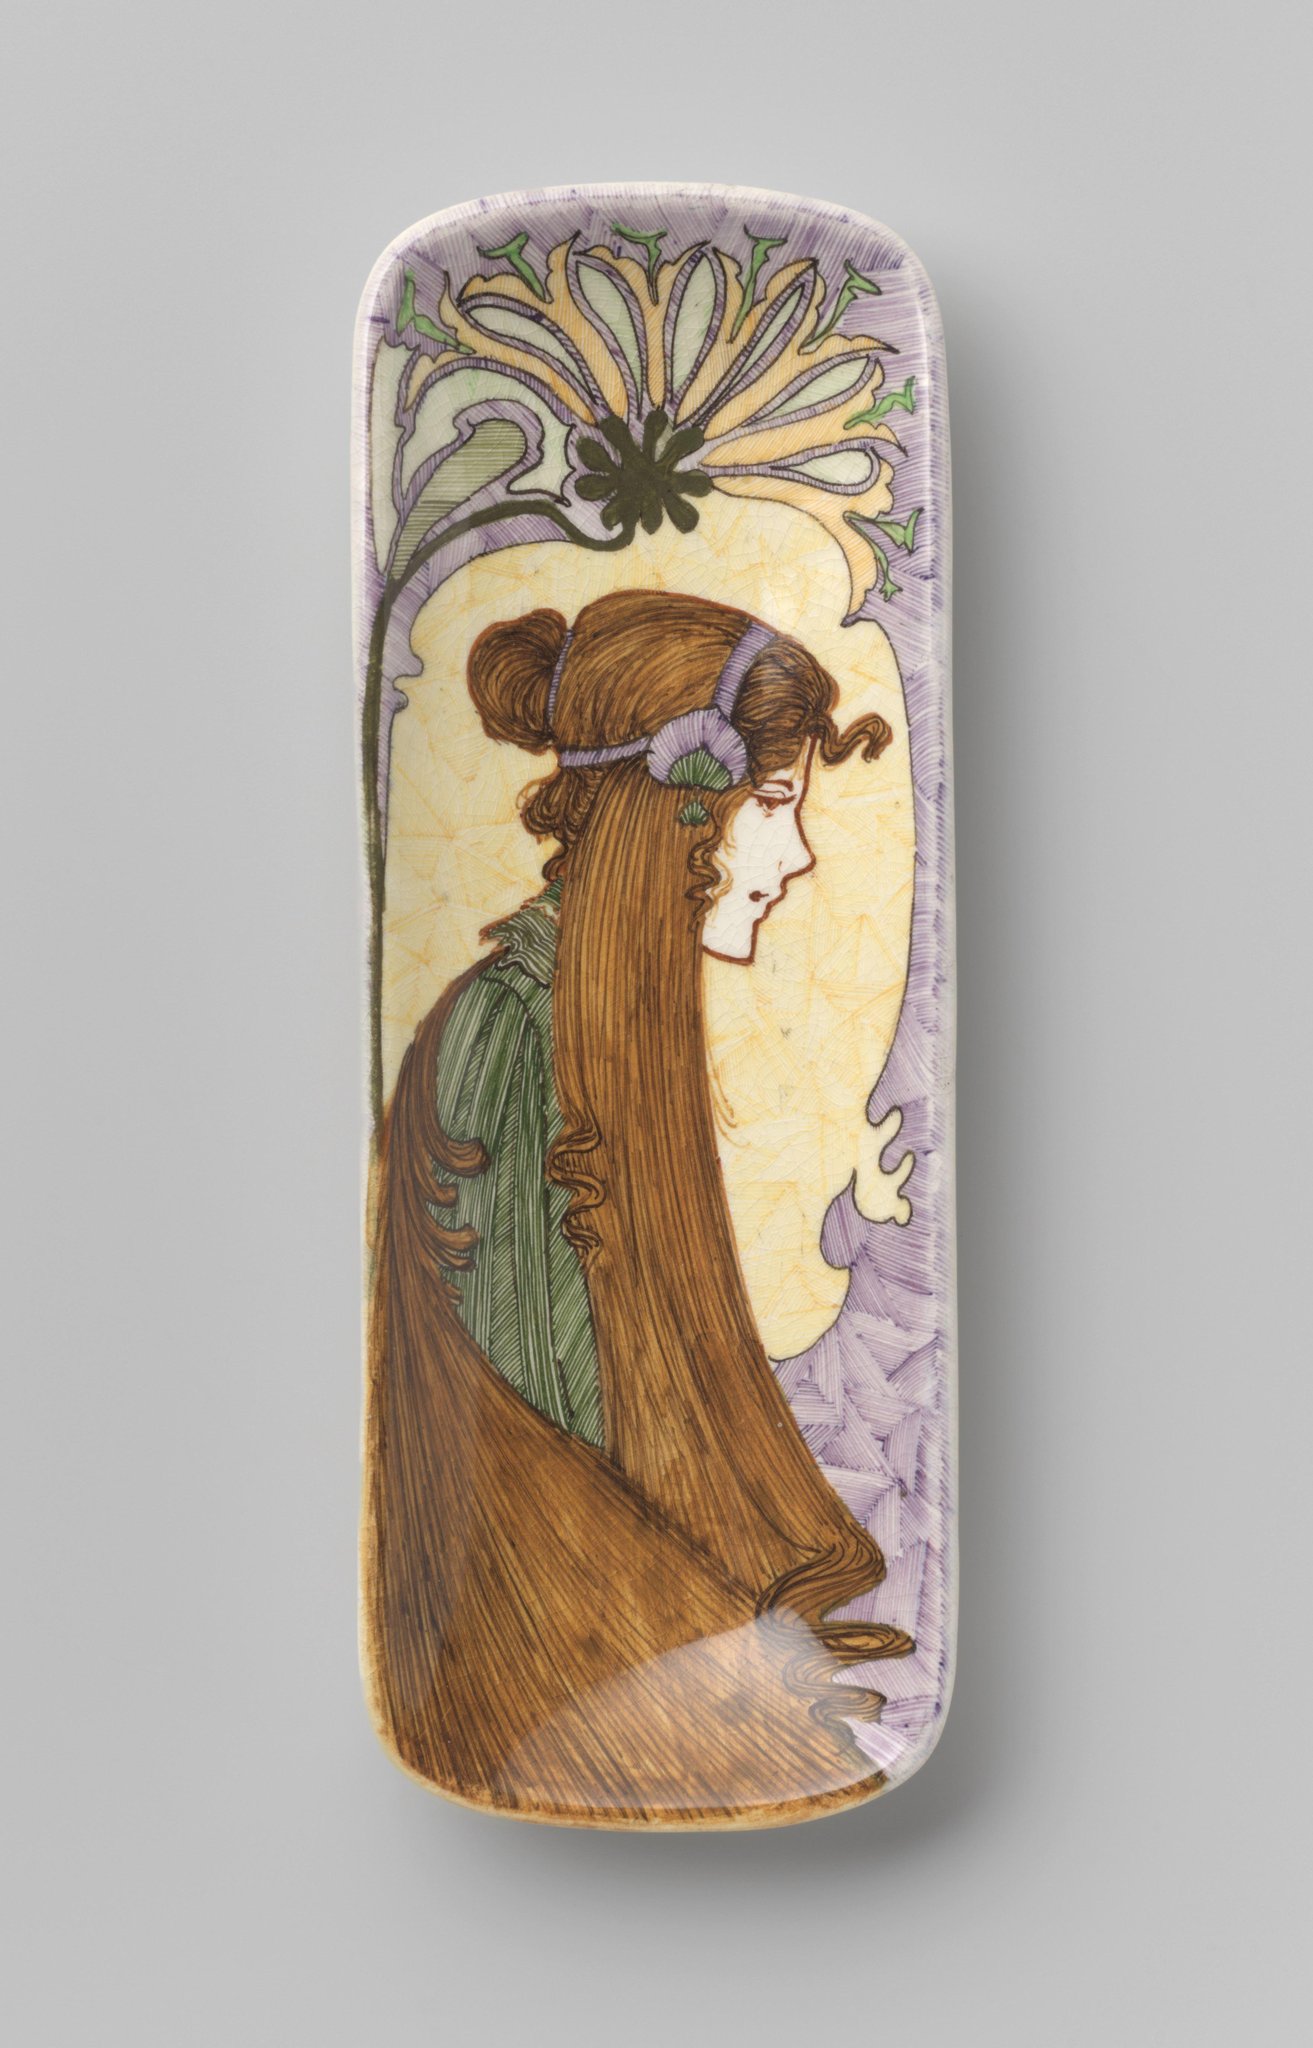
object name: container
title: Bak, beschilderd met vrouwenfiguur in profiel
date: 1910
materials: earthenware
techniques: painted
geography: gouda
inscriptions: mark: ‘Made in ; fabrieksmerk ; Zuid-Holland ; P/a ; S (alles in zwart) ; 252 (ingegrift)’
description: Bak van aardewerk, rechthoekig, met afgeronde hoeken, beschilderd met een vrouwenfiguur in profiel en ten halven lijve met lange haren in groen, bruin, rood en paars tegen een lichtgele fond. Om het gele veld een paars gearceerd decor met bloem in licht- en donkergroen en geel.